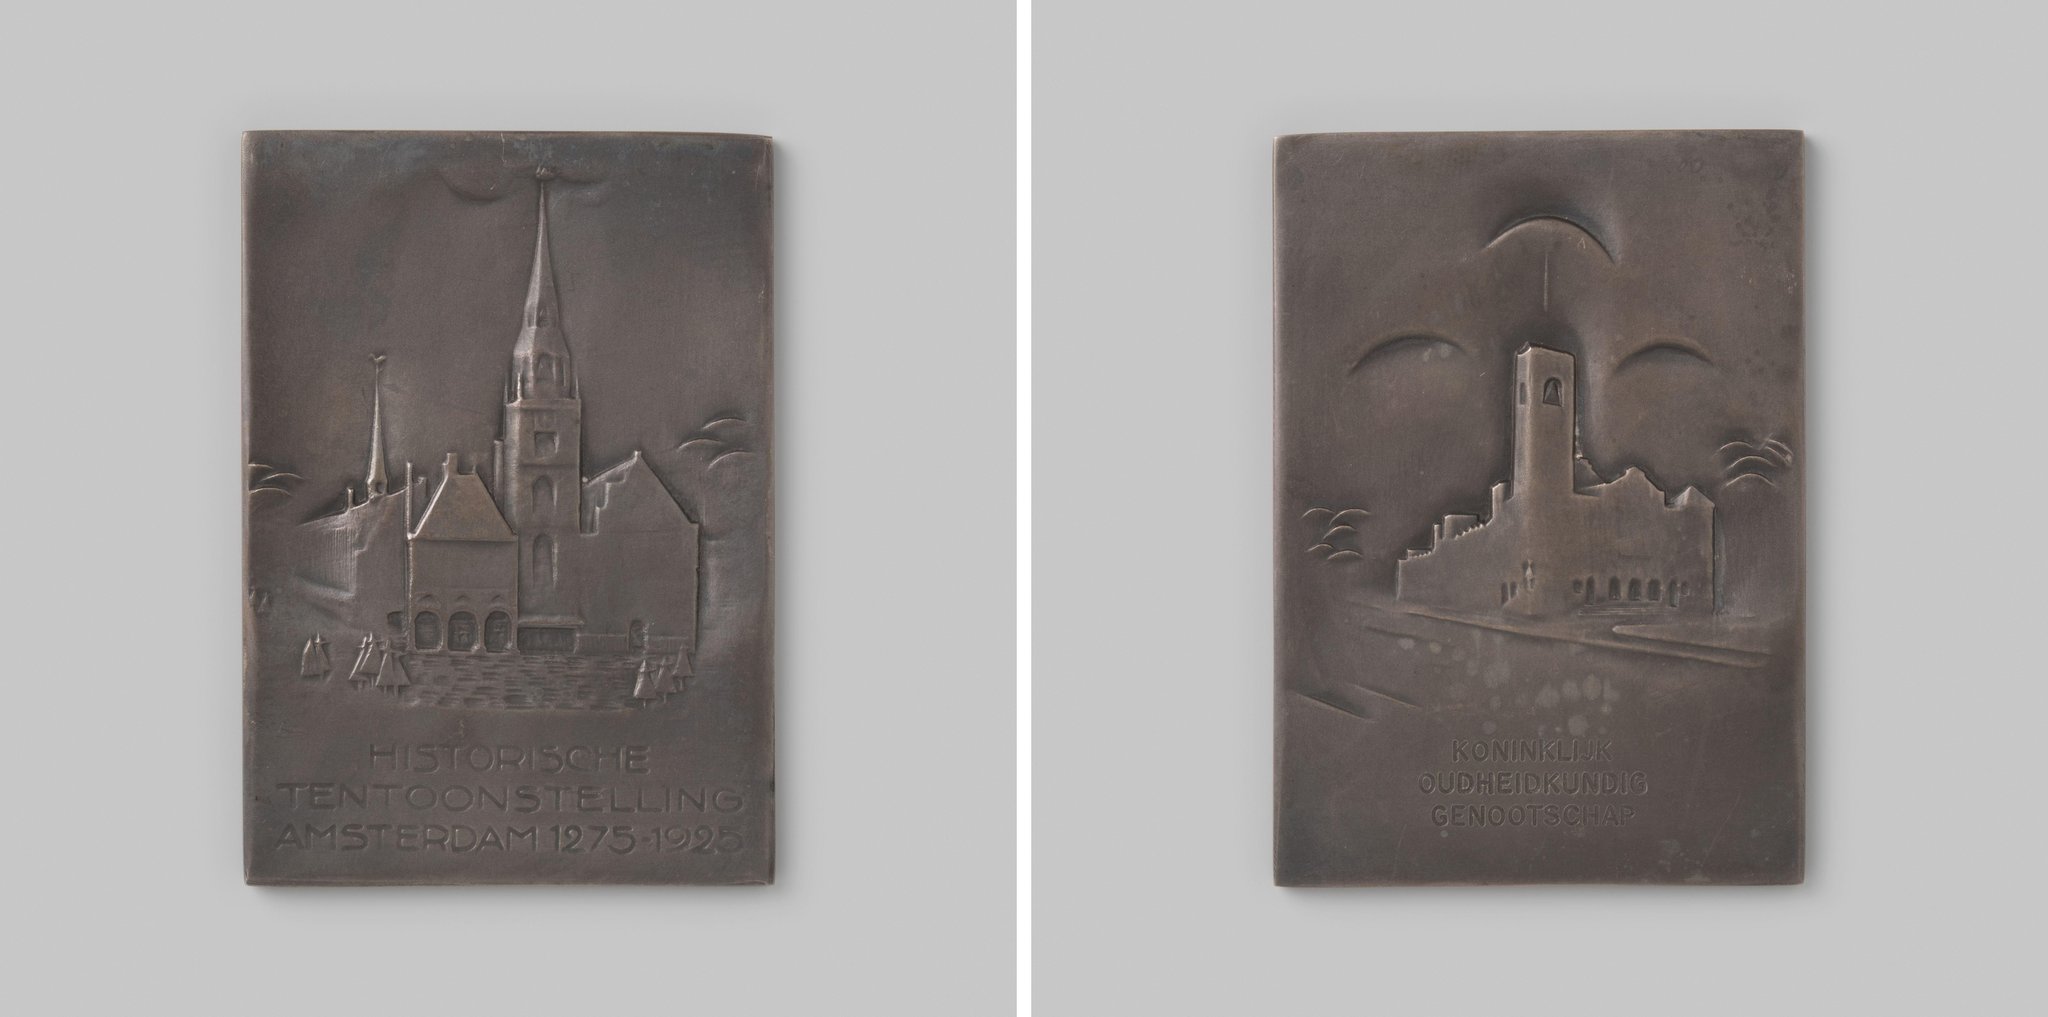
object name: medal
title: Prijsplakette van de Historische Tentoonstelling Amsterdam 1275-1925 op naam van het Koninklijk Oudheidkundig Genootschap 1925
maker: bernard richters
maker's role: print maker, sculptor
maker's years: 1888-1966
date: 1925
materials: silver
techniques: striking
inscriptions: inscription: ‘KONINKLIJK / OUDHEIDKUNDIG / GENOOTSCHAP’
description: Rechthoekige zilveren plakette, op de voorzijde het oude stadhuis van Amsterdam waaronder drie regels incuse tekst, op de keerzijde de Beurs van Berlage waaronder een drieregelige inscriptie.